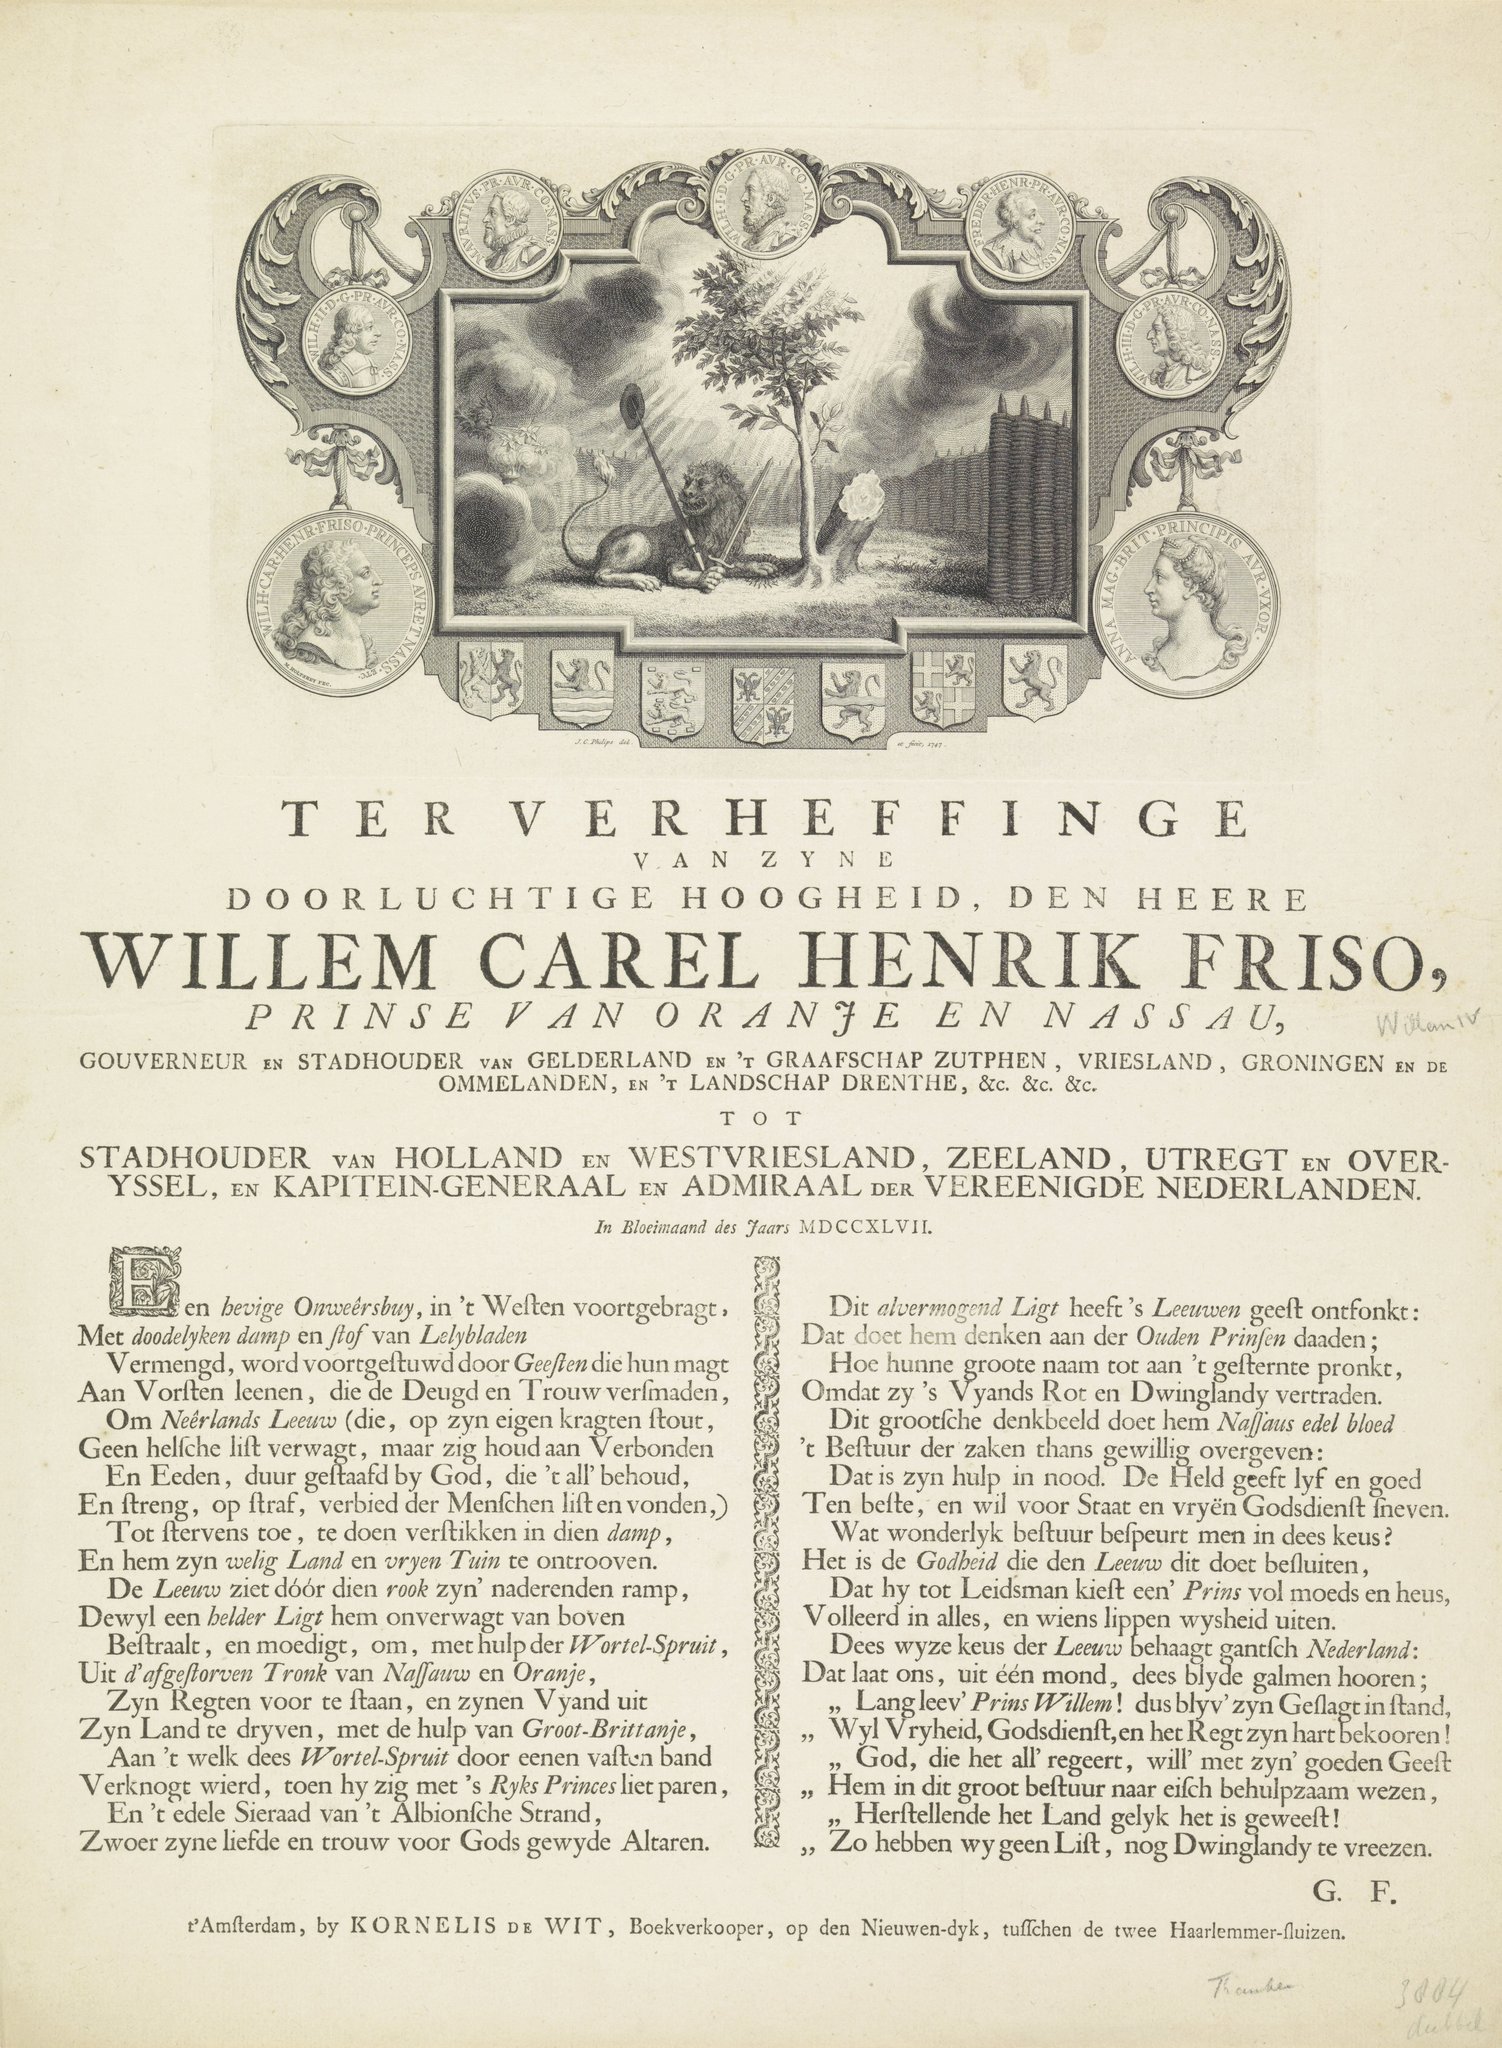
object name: print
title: Ter Verheffinge van zyne doorluchtige hoogheid, den heere Willem Carel Henrik Friso (...) tot Stadhouder van Holland en Westvriesland, Zeeland, Utregt en Overyssel, en Kapitein-Generaal en Admiraal der Vereenigde Nederlanden. In Bloeimaand des Jaars MDCCXLVII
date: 1747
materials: paper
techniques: engraving, etching, letterpress printing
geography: amsterdam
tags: william iii (prince of orange and king of england, scotland, and ireland), frederick henry (prince of orange), william ii (prince of orange), delft, william i (prince of orange), the hague, maurice (prince of orange), willem iv (prins van oranje-nassau), anna van hannover, fenced or walled garden; 'hortus conclusus'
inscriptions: collector's mark: Lugt 2228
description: Allegorie op de verheffing van Willem IV tot erfstadhouder in mei 1747. De Nederlandse Leeuw met zwaard, lans en vrijheidshoed wakend in de Hollandse Tuin bij de door het goddelijke licht beschenen Oranjeboom. In omlijsting met wapens van de zeven provincies en portretmedaillons van prins Willem IV en zijn echtgenote Anna en de eerdere prinsen van Oranje. Op het blad onder de plaat een vers in twee kolommen gesigneerd G.F.